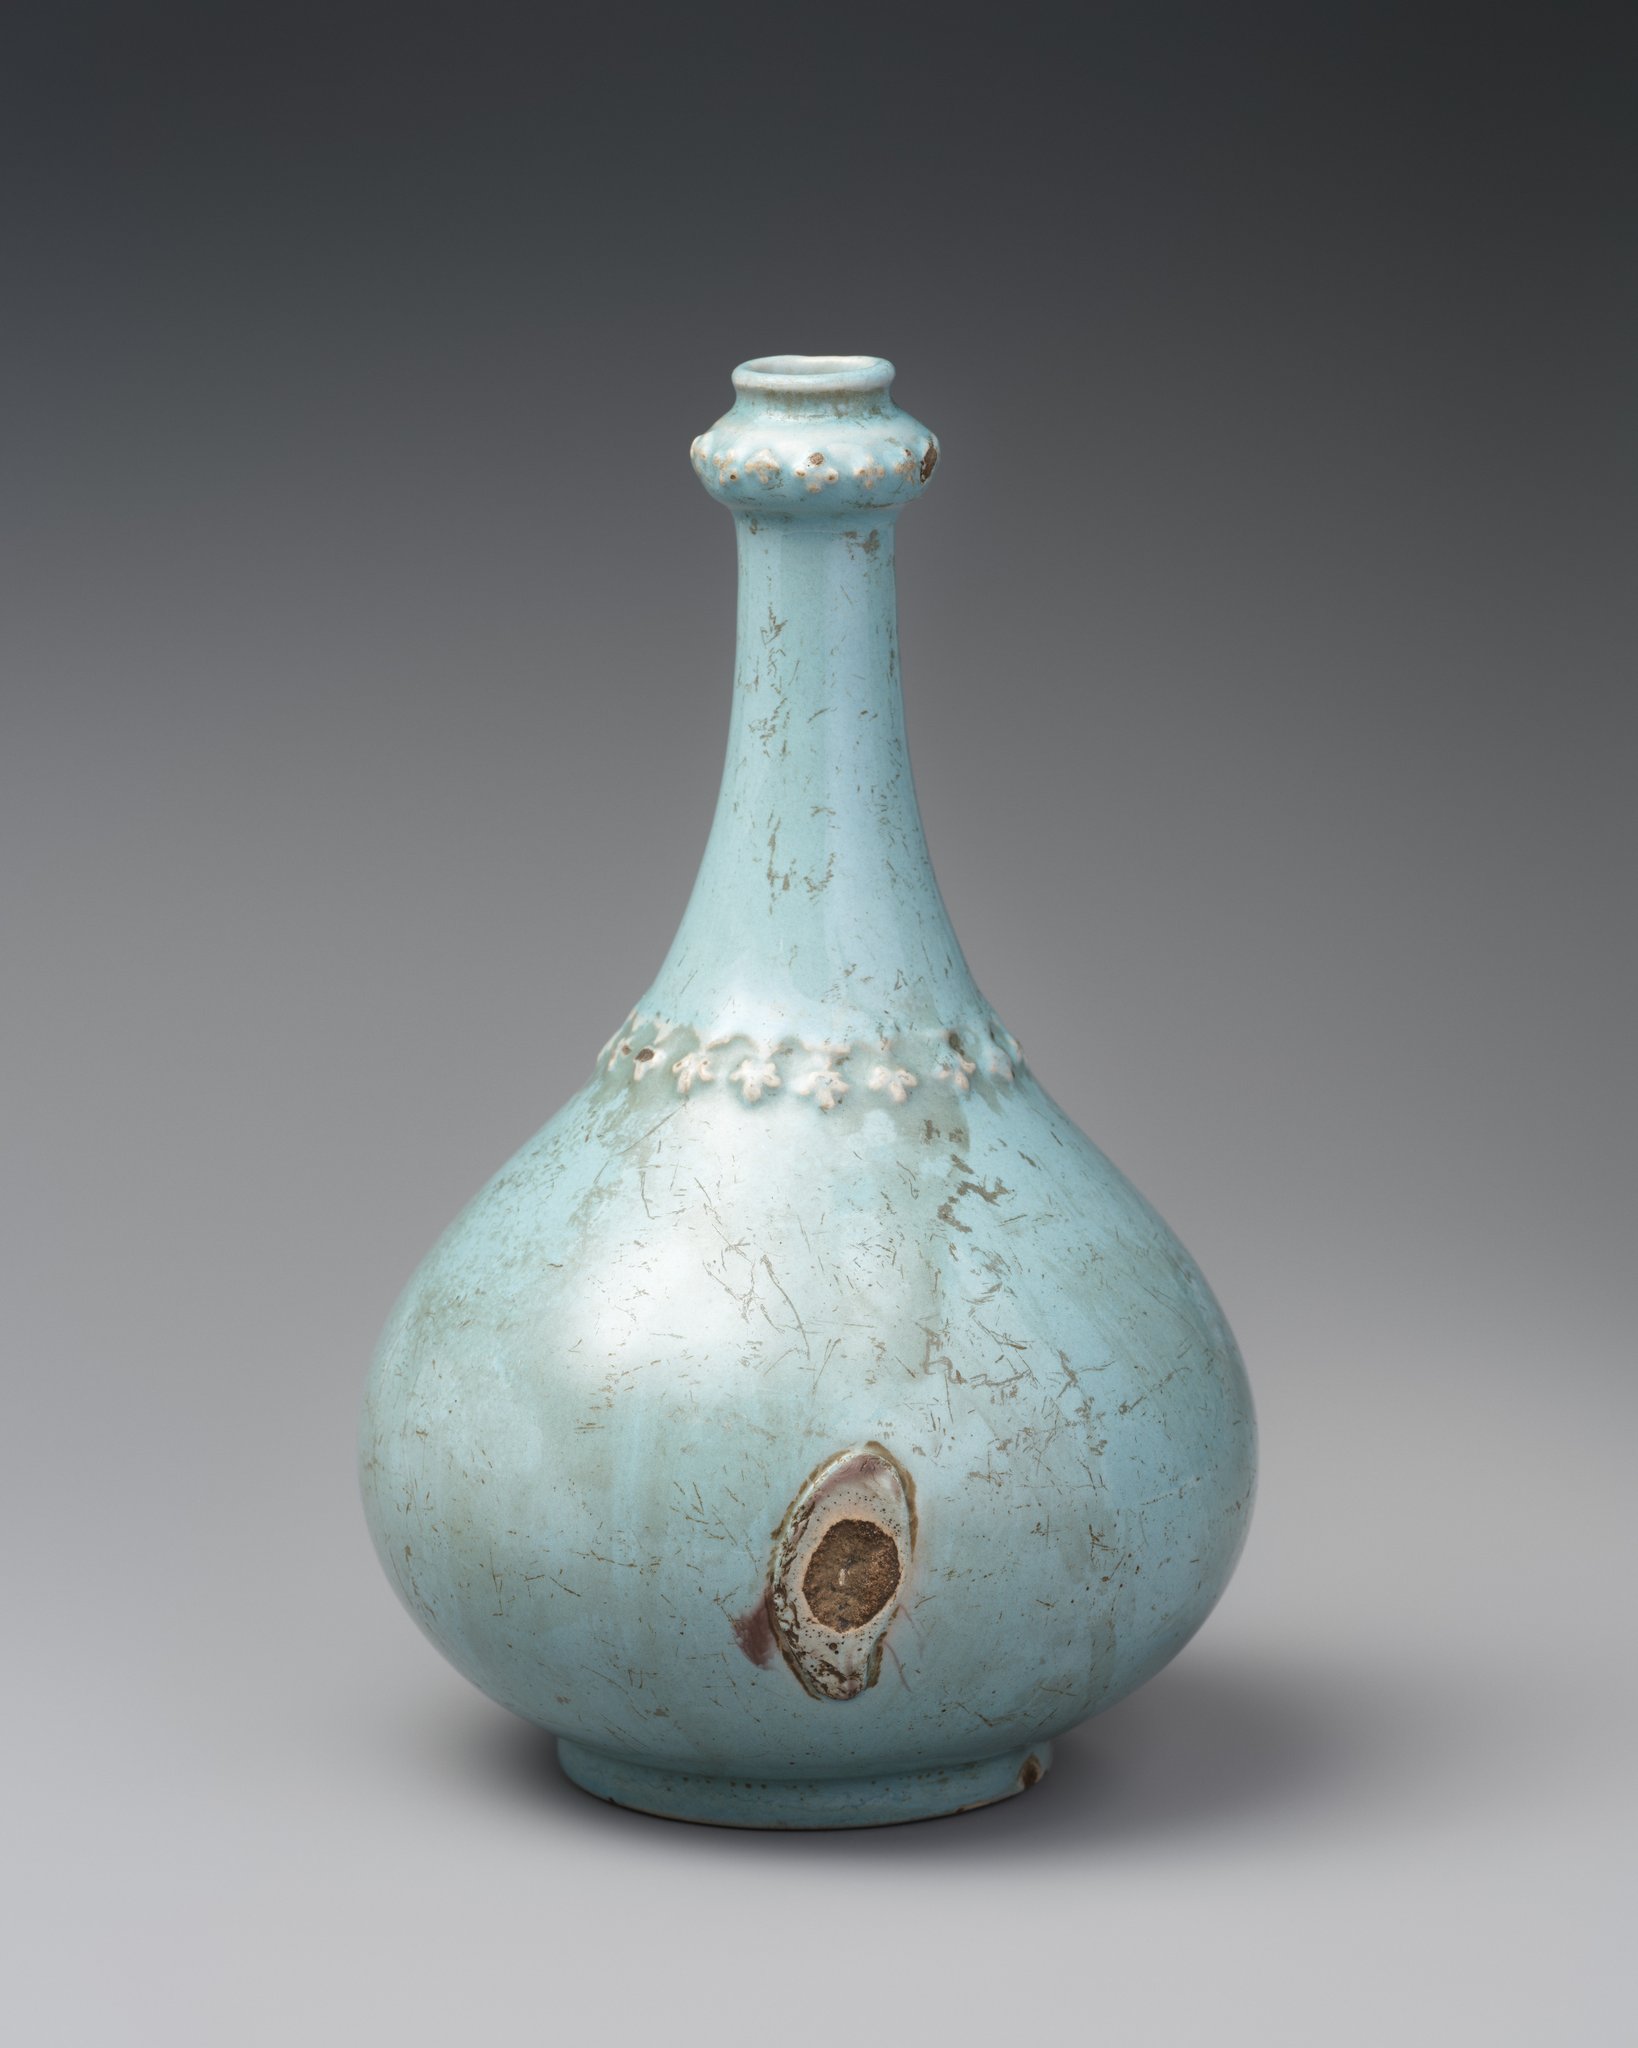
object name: bottle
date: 1601-1800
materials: earthenware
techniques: glazing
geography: iran